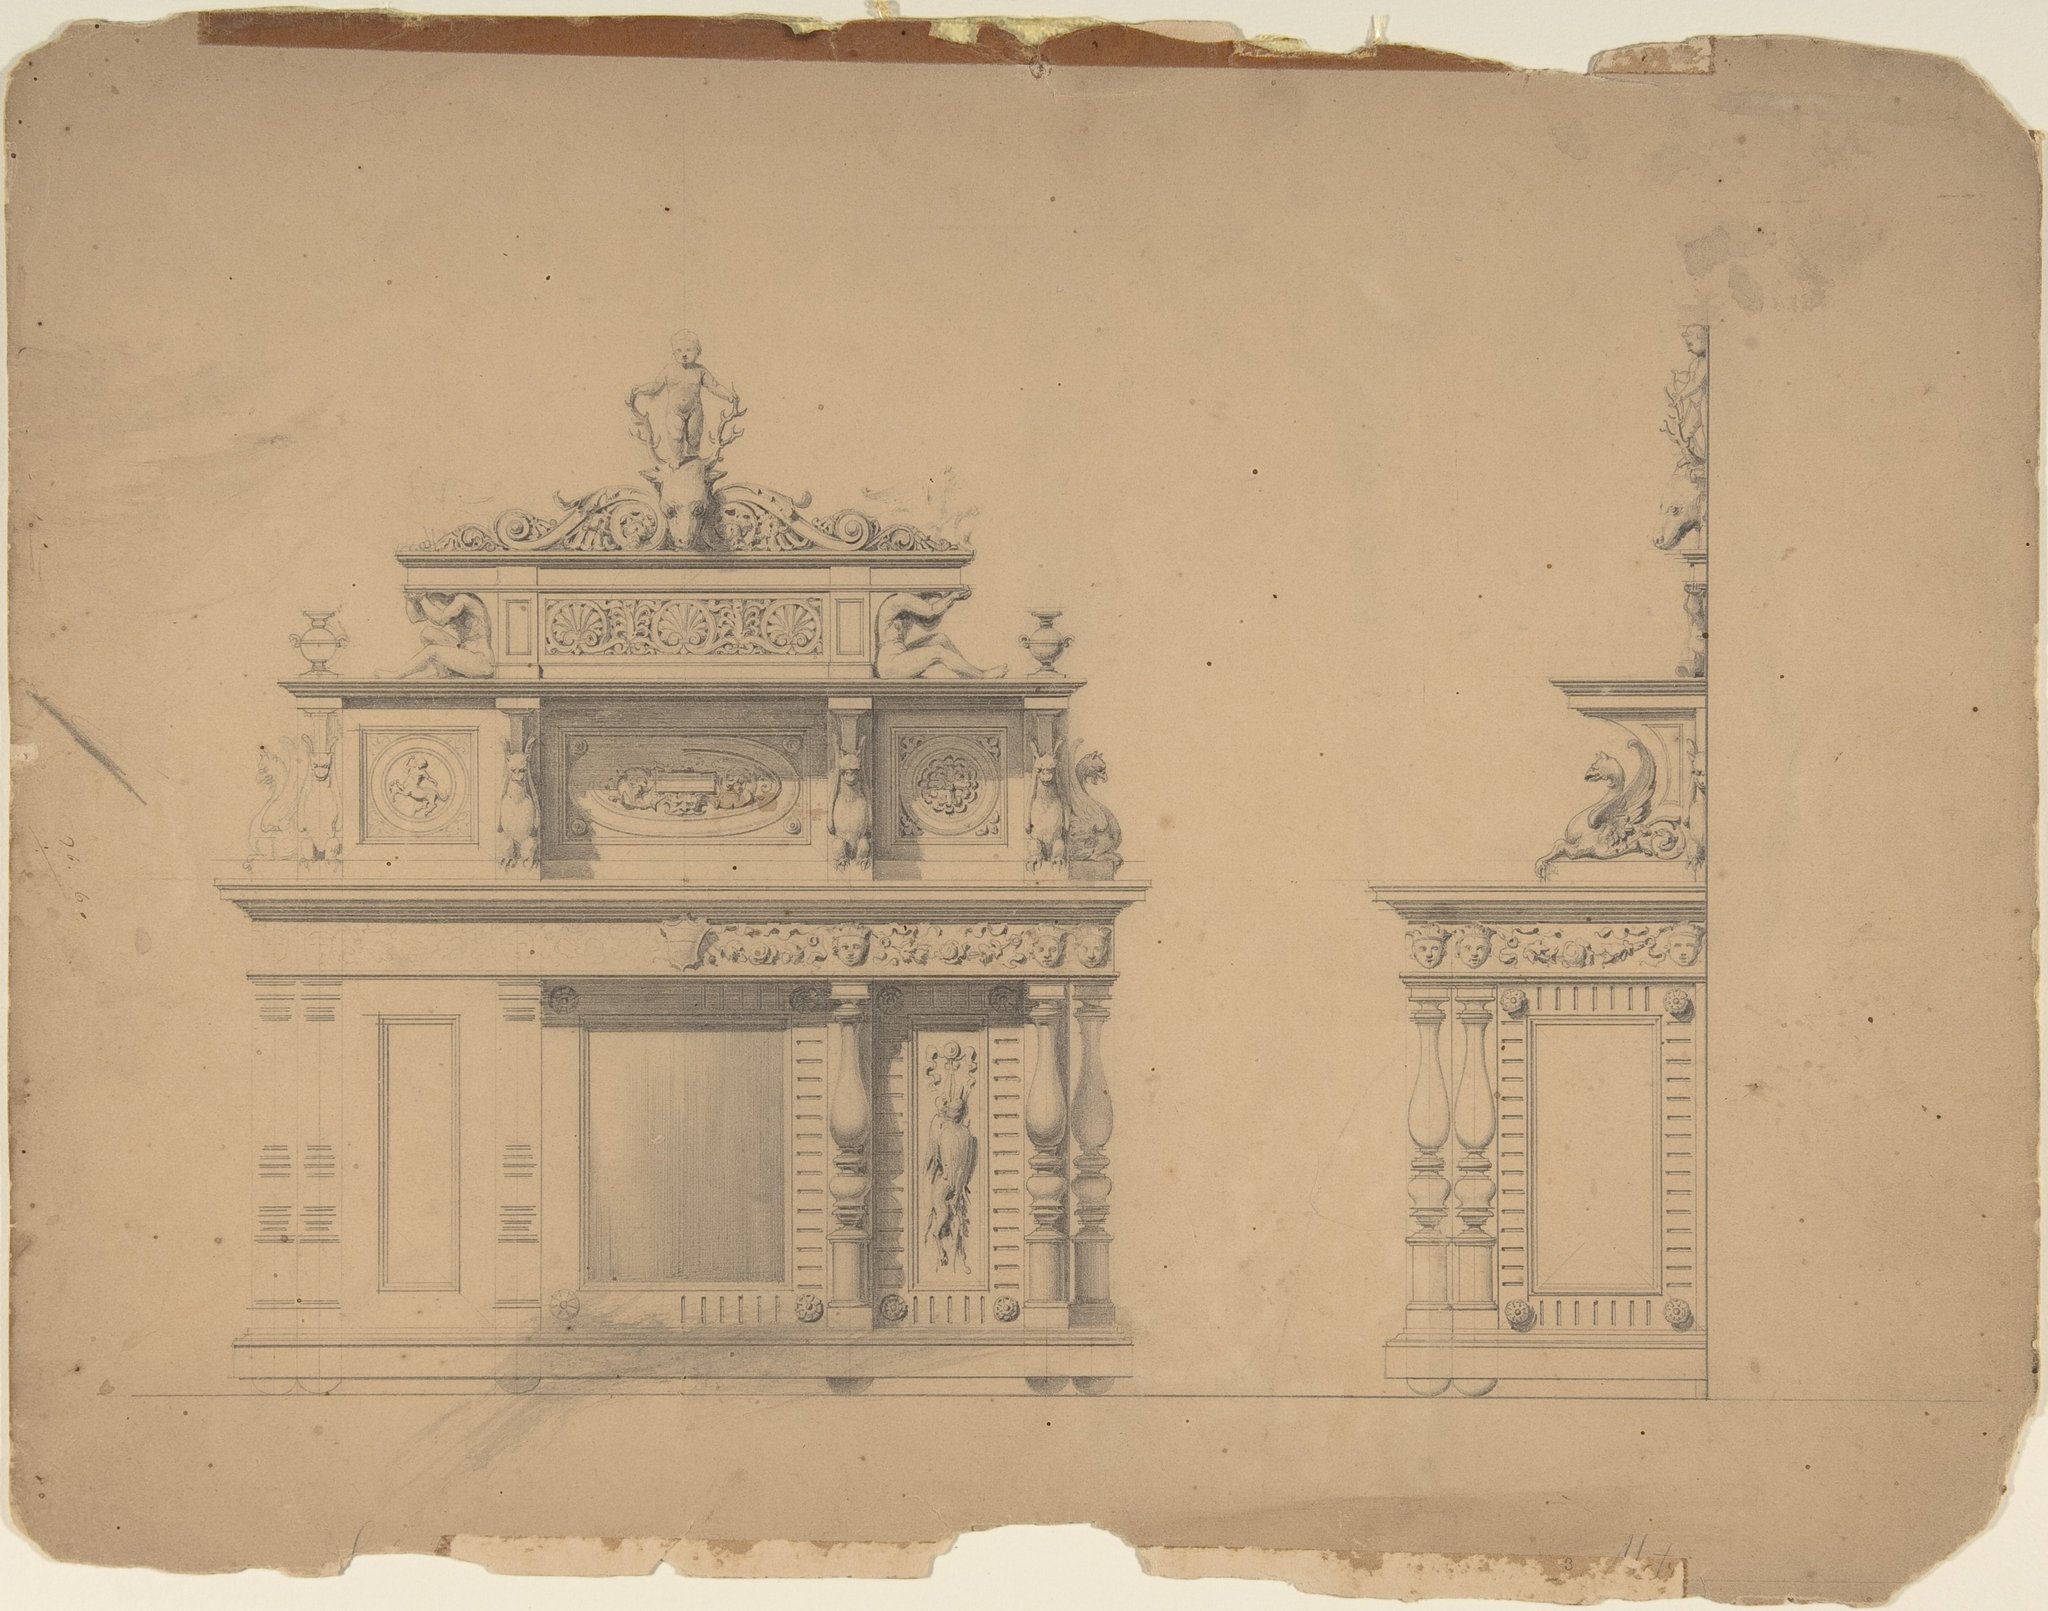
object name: drawing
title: Furniture Designs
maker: anonymous, italian, 19th century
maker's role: artist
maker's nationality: italian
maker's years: 1800-1900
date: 1800-1900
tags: furniture